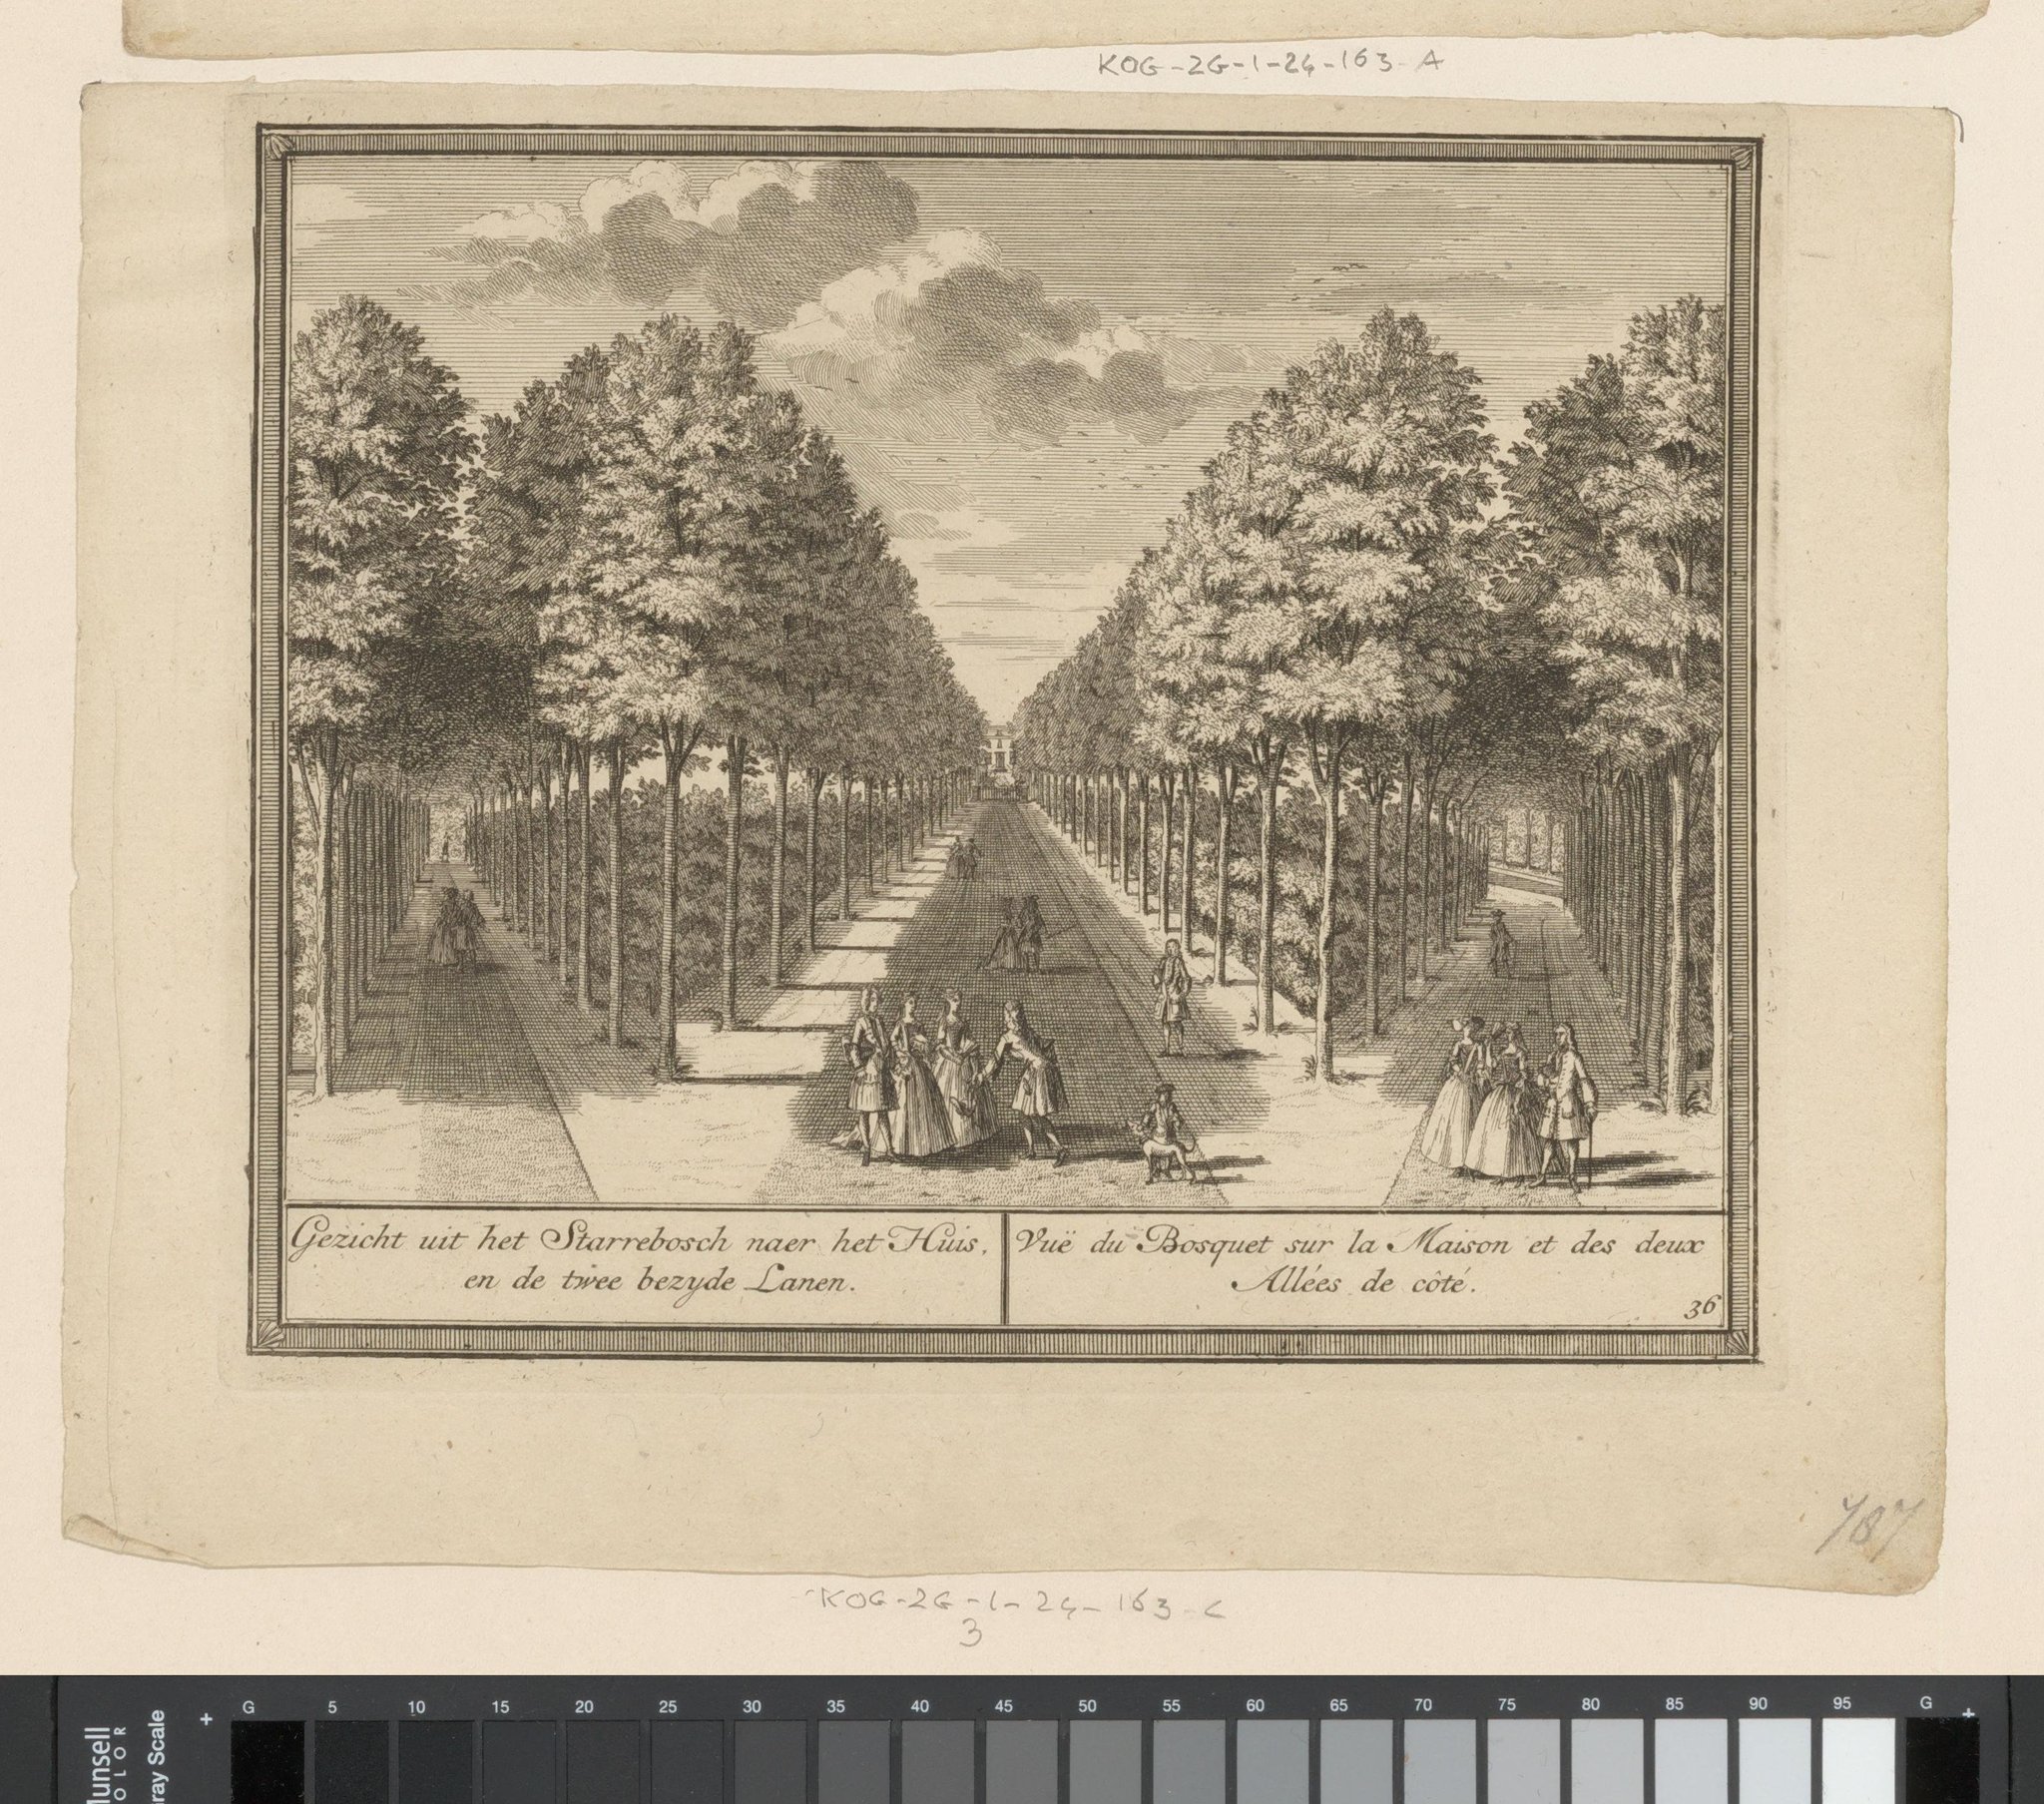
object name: print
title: Gezicht uit het Starrebosch naer het Huis en de twee bezijde Lanen / Vuë du Bosquet sur la Maison et des deux Allées de côté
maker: hendrik de leth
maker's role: draughtsman, print maker, publisher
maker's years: 1703-1766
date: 1729-1732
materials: paper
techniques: engraving, etching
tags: country-house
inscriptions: stamp, collector's mark: Lugt 1641, stamp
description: Prent mogelijk uit: Brouërius van Nidek, Matthaeus. Het zegepralend Kennemerland, vertoond in 100 heerlyke gezichten. Amsterdam: Jan Roman, s.a. Of uit: Brouërius van Nidek, Matthaeus. Het zegepralend Kennemerland, vertoond in veele heerlyke gezichten. Amsterdam: Andries en Hendrik de Leth, s.a [1729-1732].